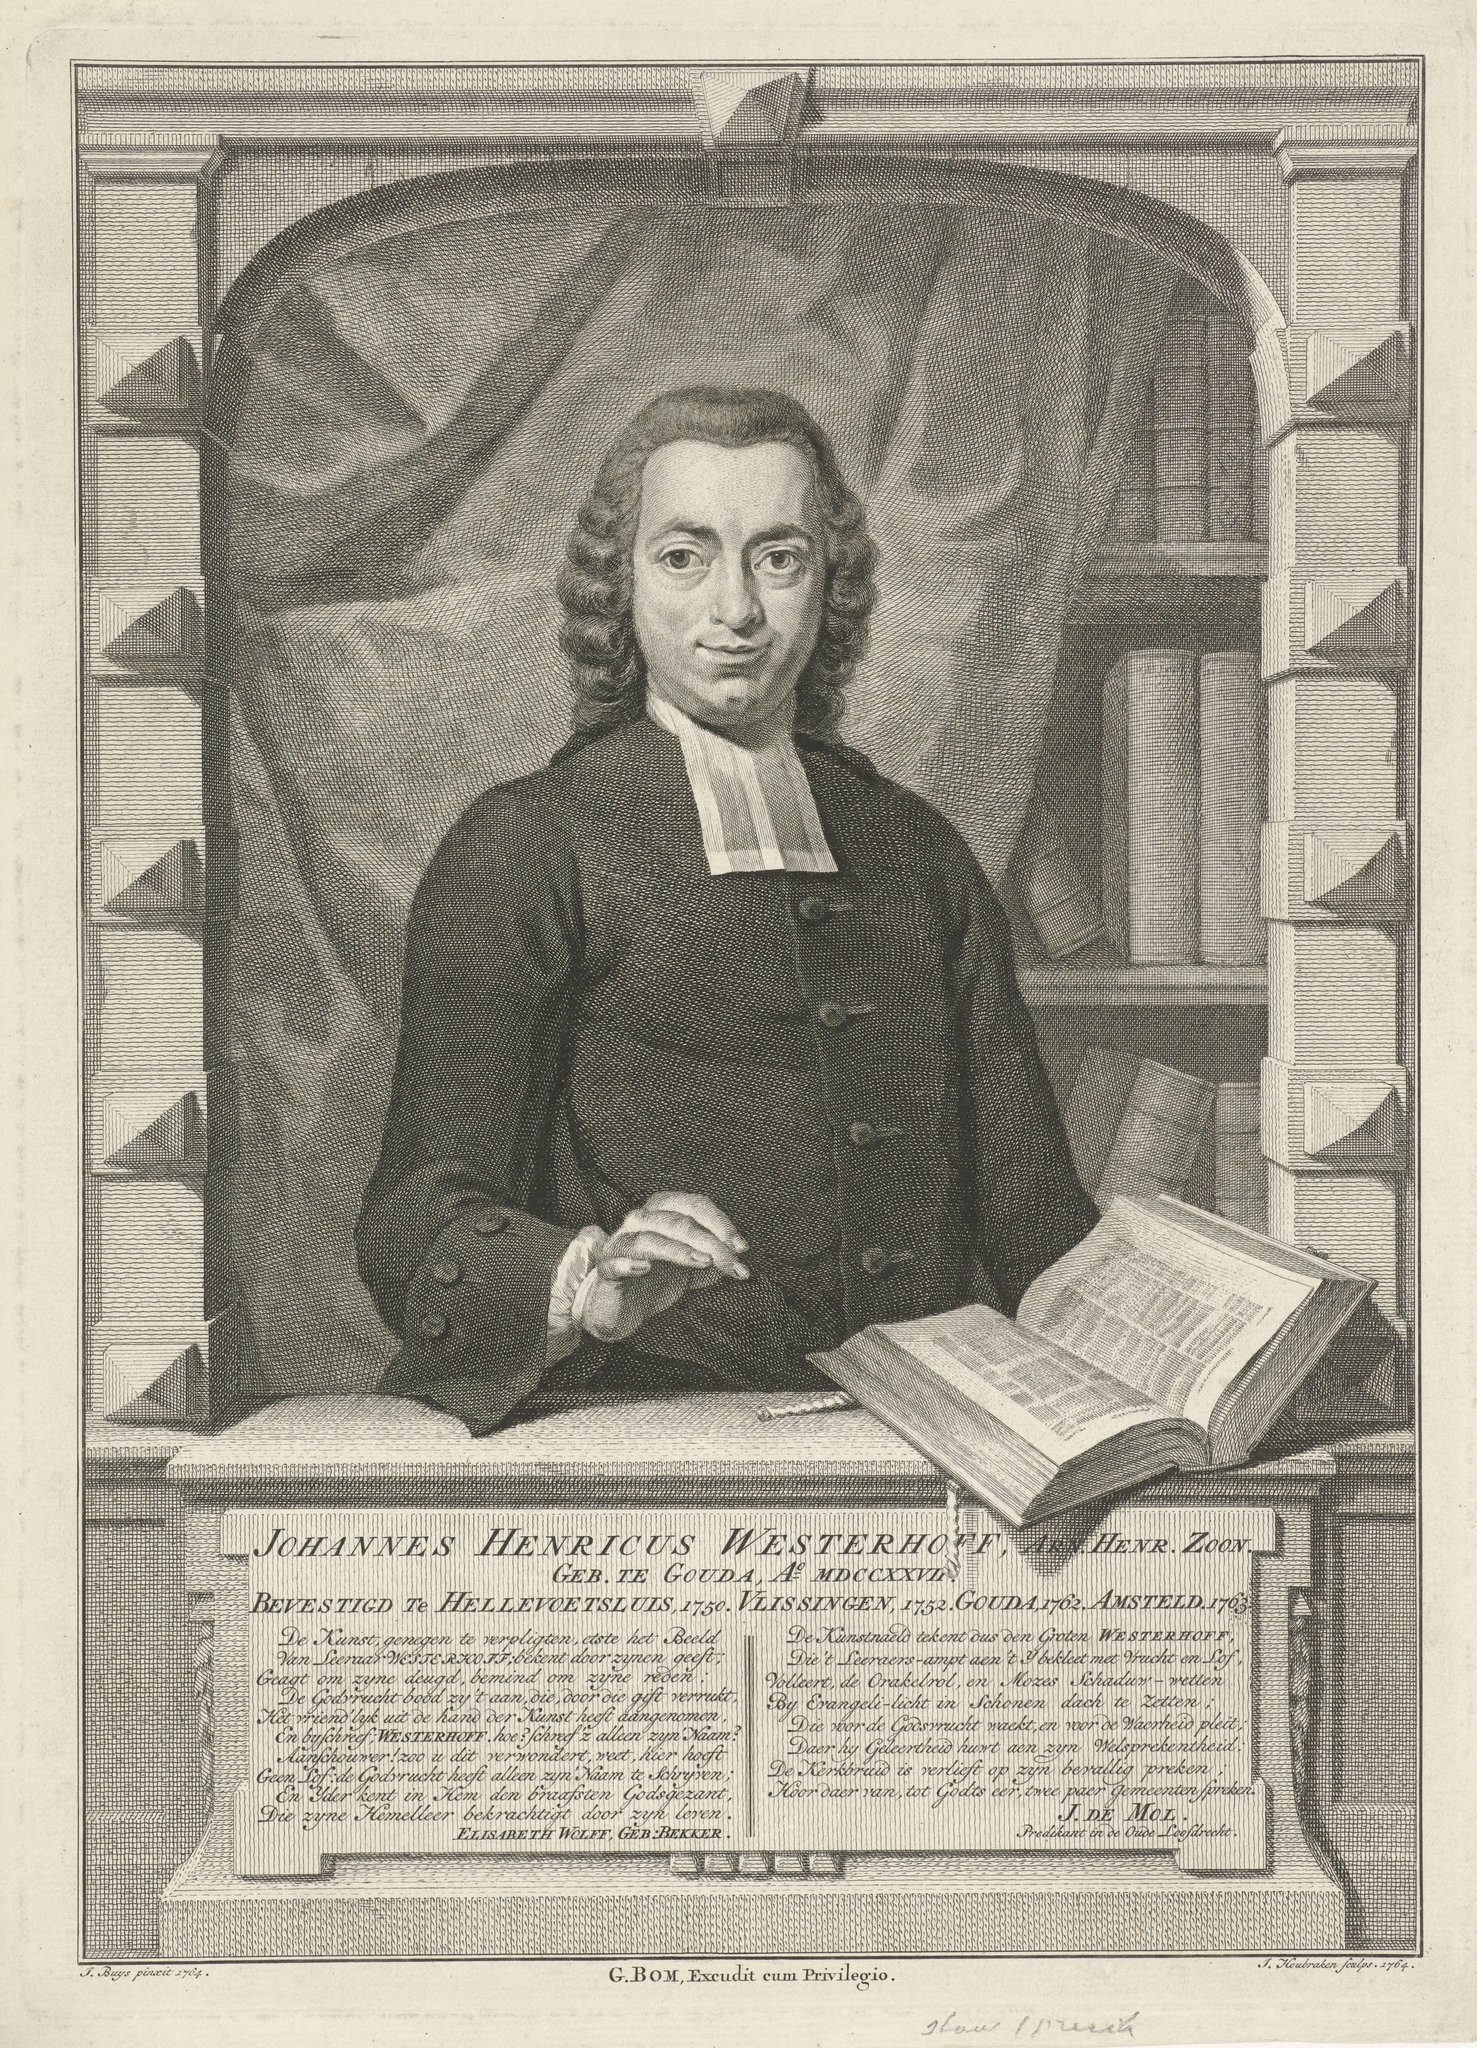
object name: print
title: Portret van Johannes Henricus Westerhoff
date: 1764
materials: paper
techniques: engraving, etching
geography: amsterdam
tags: gouda, amsterdam, the bible as a book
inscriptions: collector's mark: Lugt 2228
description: Portret ten halven lijve van Johannes Henricus Westerhoff, in een architectonische venstervormige omlijsting, met voor hem een opengeslagen bijbel. Onder de vensterbank een plaquette met daarop de naam en gegevens van de geportretteerde in drie regels in het Nederlands en daaronder twee naast elkaar geplaatste verzen: links een tienregelig vers in het Nederlands en rechts een achtregelig vers in het Nederlands.